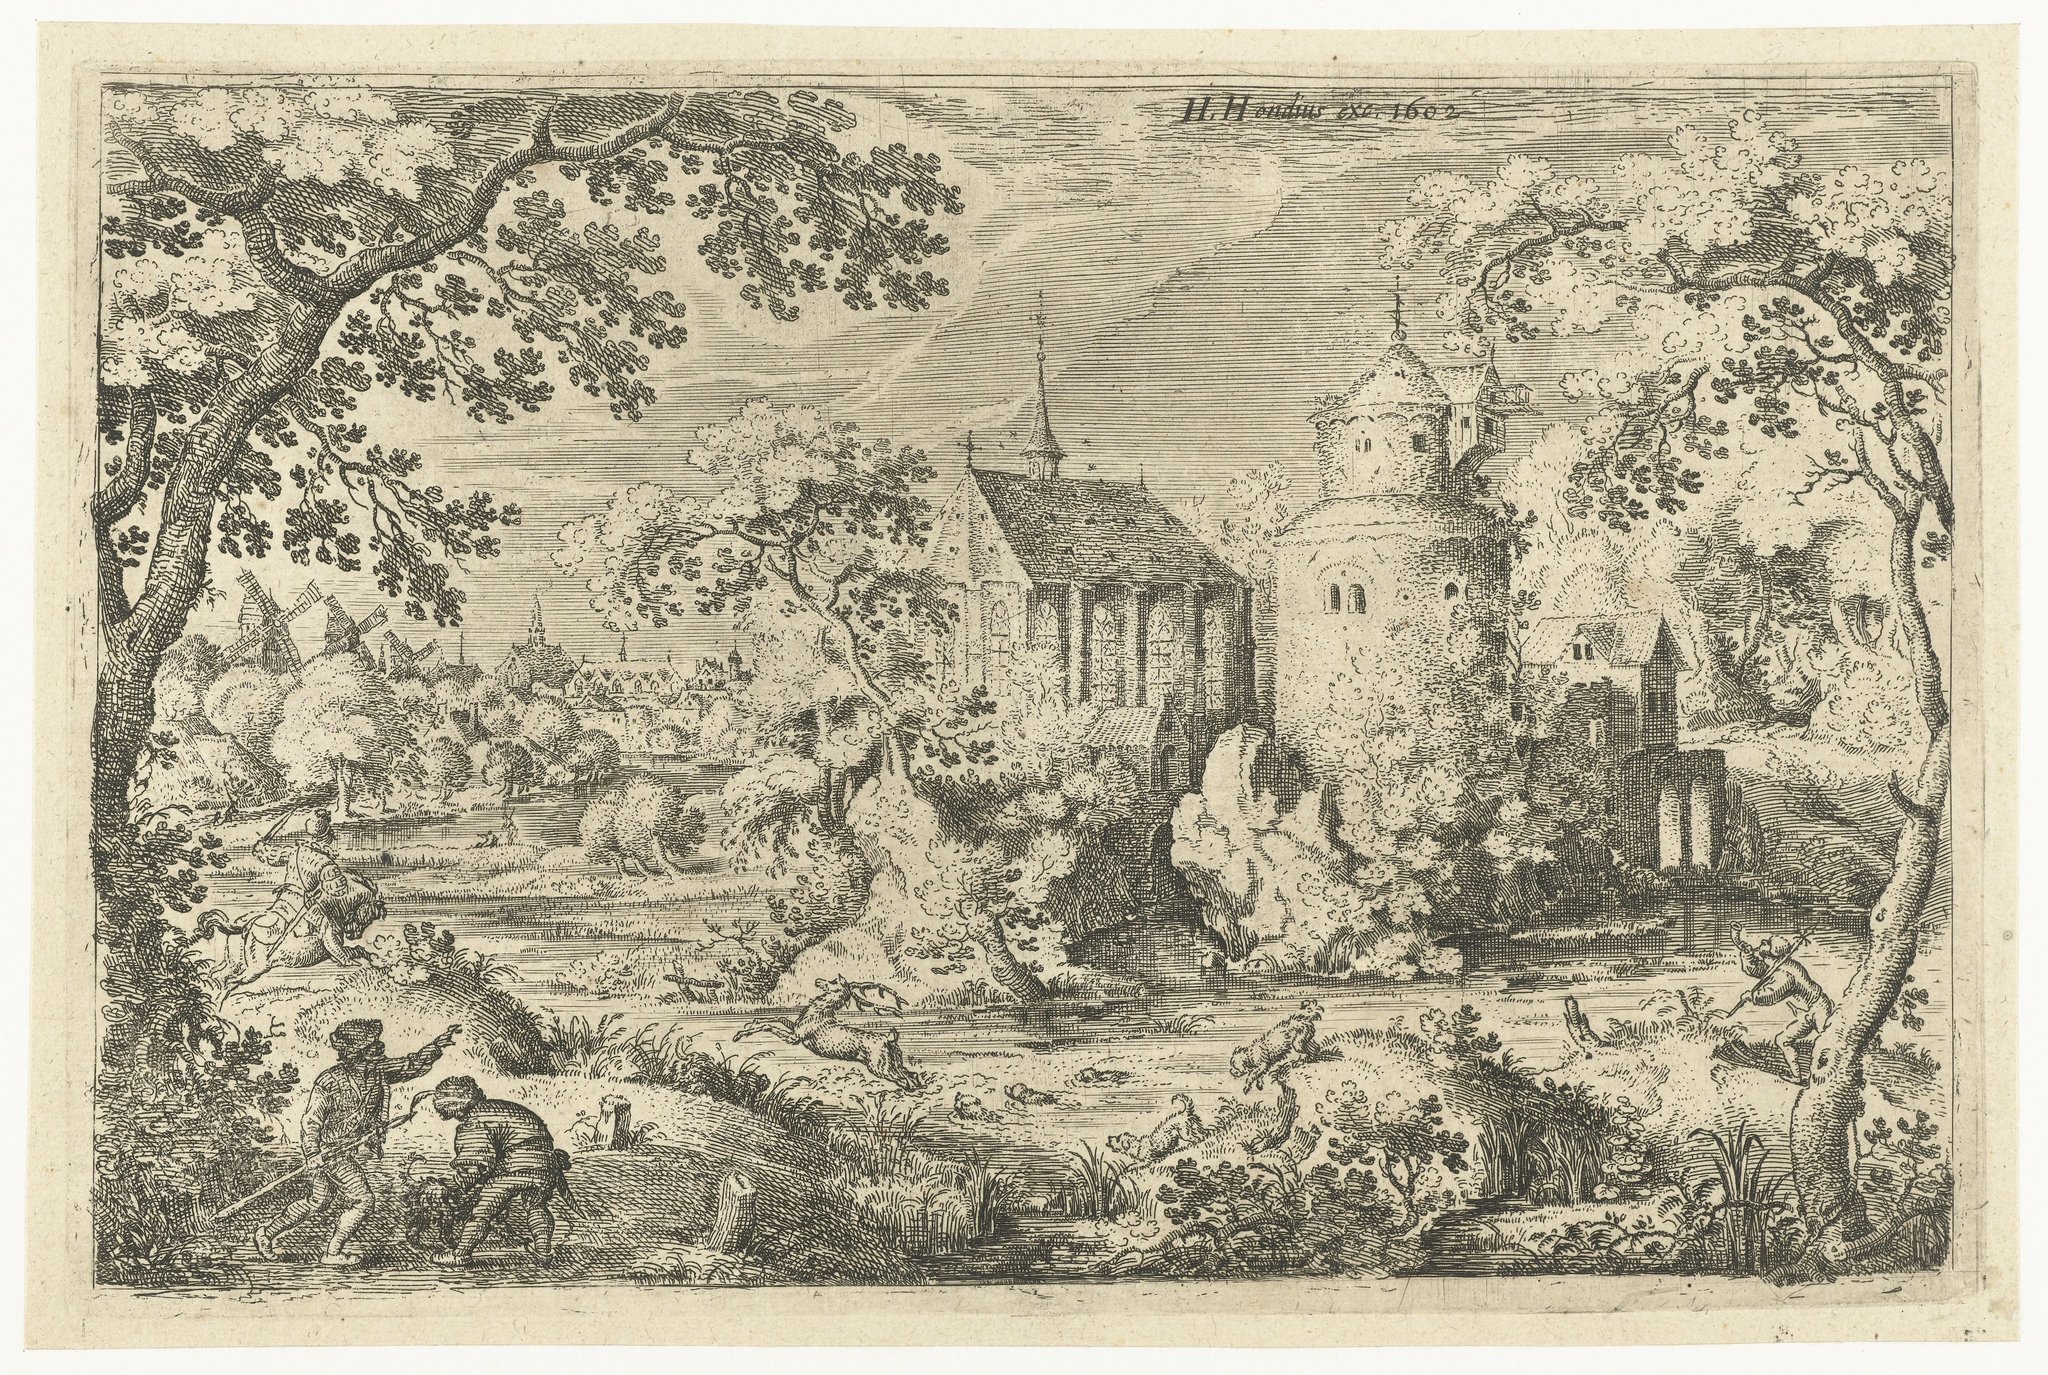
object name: print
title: Hertenjacht bij een kapel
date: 1602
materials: paper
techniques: engraving, etching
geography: netherlands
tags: hoofed animals: deer, stag-hunting, sports, games ~ animals (+ hunting with dogs)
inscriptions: collector's mark: ‘RYKSMUSM’ Lugt 2228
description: In een bomenrijk moeras in de nabijheid van een dorp en een kapel jagen een aantal mannen met hun honden op een hert. Pendant van 'Hertenjacht in een moeras'.